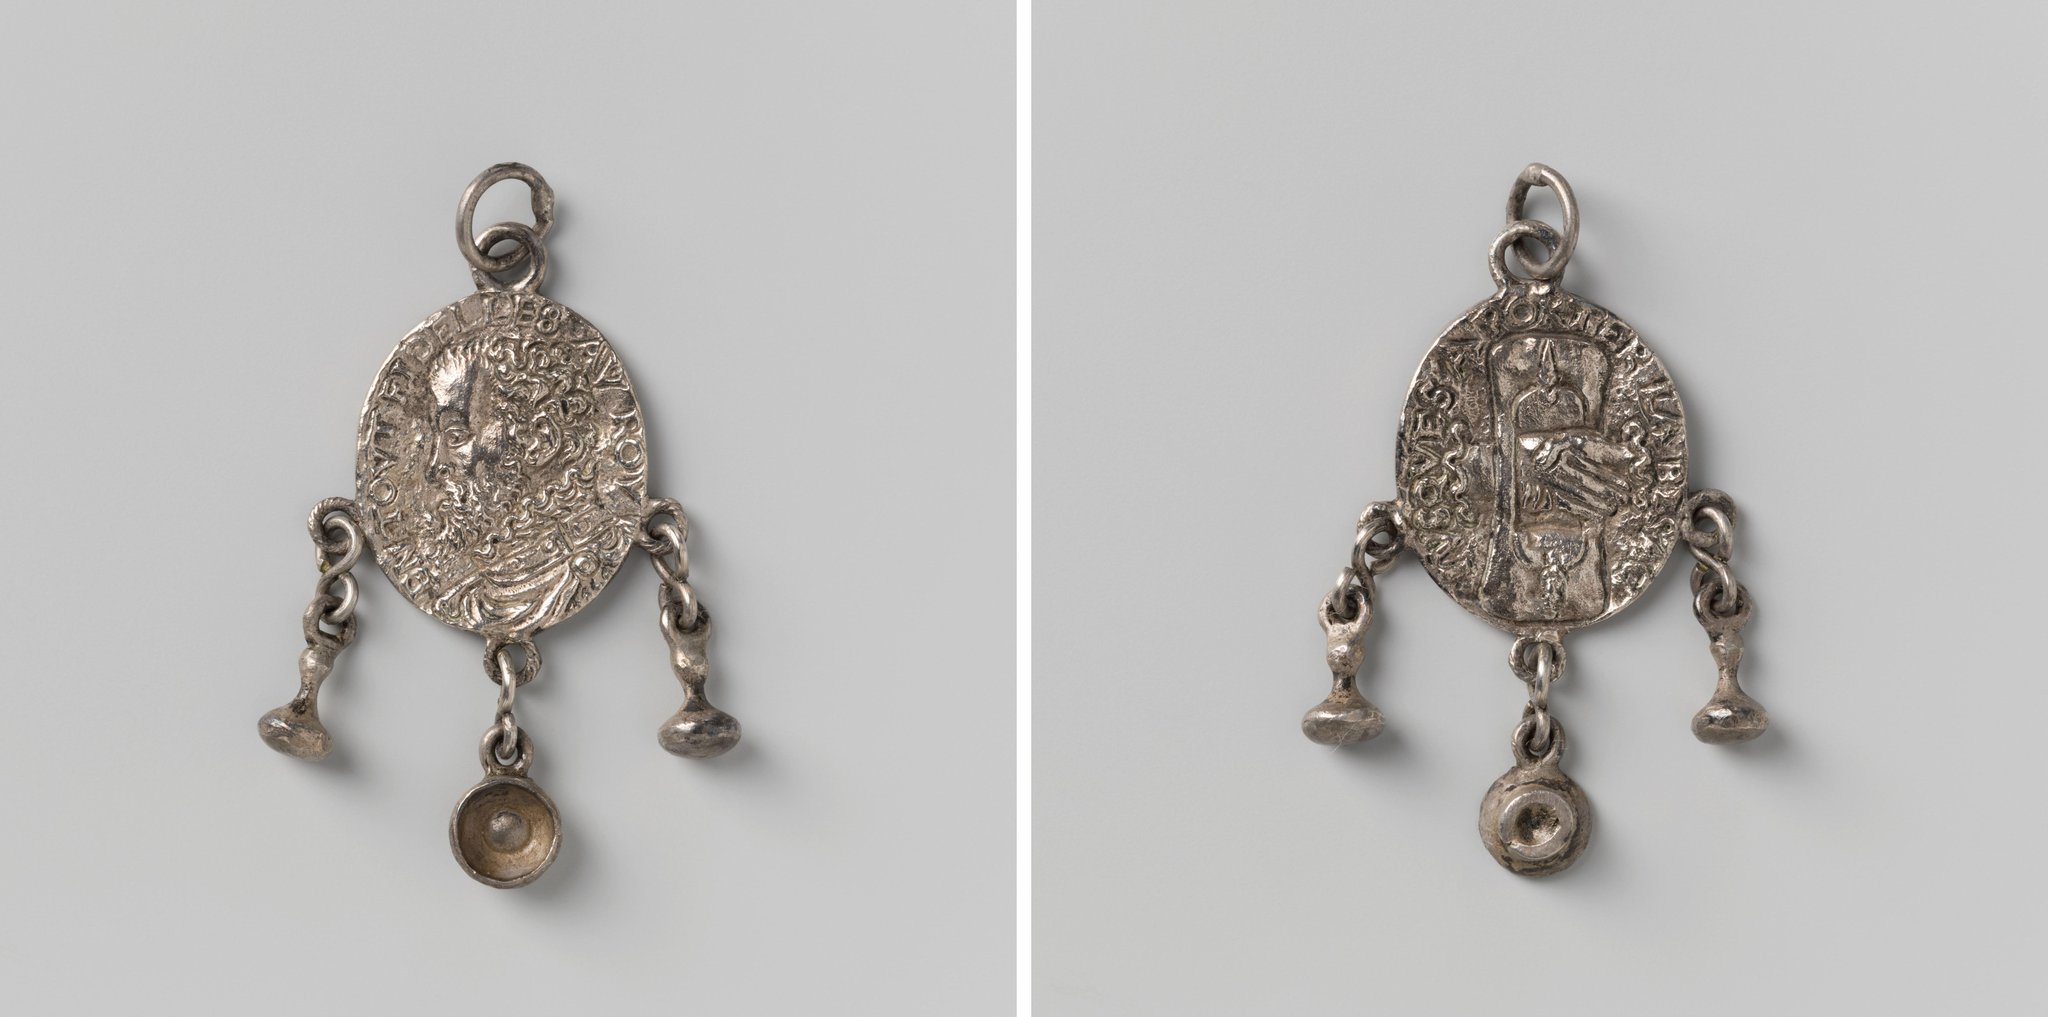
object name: copy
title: Geuzenpenning met napje en kalebasjes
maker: Anonymous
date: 1800-1900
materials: silver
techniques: casting, forging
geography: low countries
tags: philip ii of spain, spain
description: When in 1566 several hundred Dutch noblemen petitioned the Spanish authorities for greater tolerance in matters of religion, they were ridiculed as 'gueux': beggars. In response, they took the French name 'gueux' (vulgarised to 'geuzen') as a symbol of honour and wore a beggar's badge on their clothes. These were tokens that town authorities gave to beggars to show that they were legally allowed to beg. The crescent shape of the medals and the text around the edge 'Better Turkish than Papish' had several connotations. Turks had a reputation for cruelty; but they were also known for their tolerance to other religions. Moreover, the Islamic Turkish Empire was at war with Catholic Spain. Apart from badges, the Geuzen also carried small wooden begging bowls and flasks, reminiscent of the pilgrims who lived by begging.